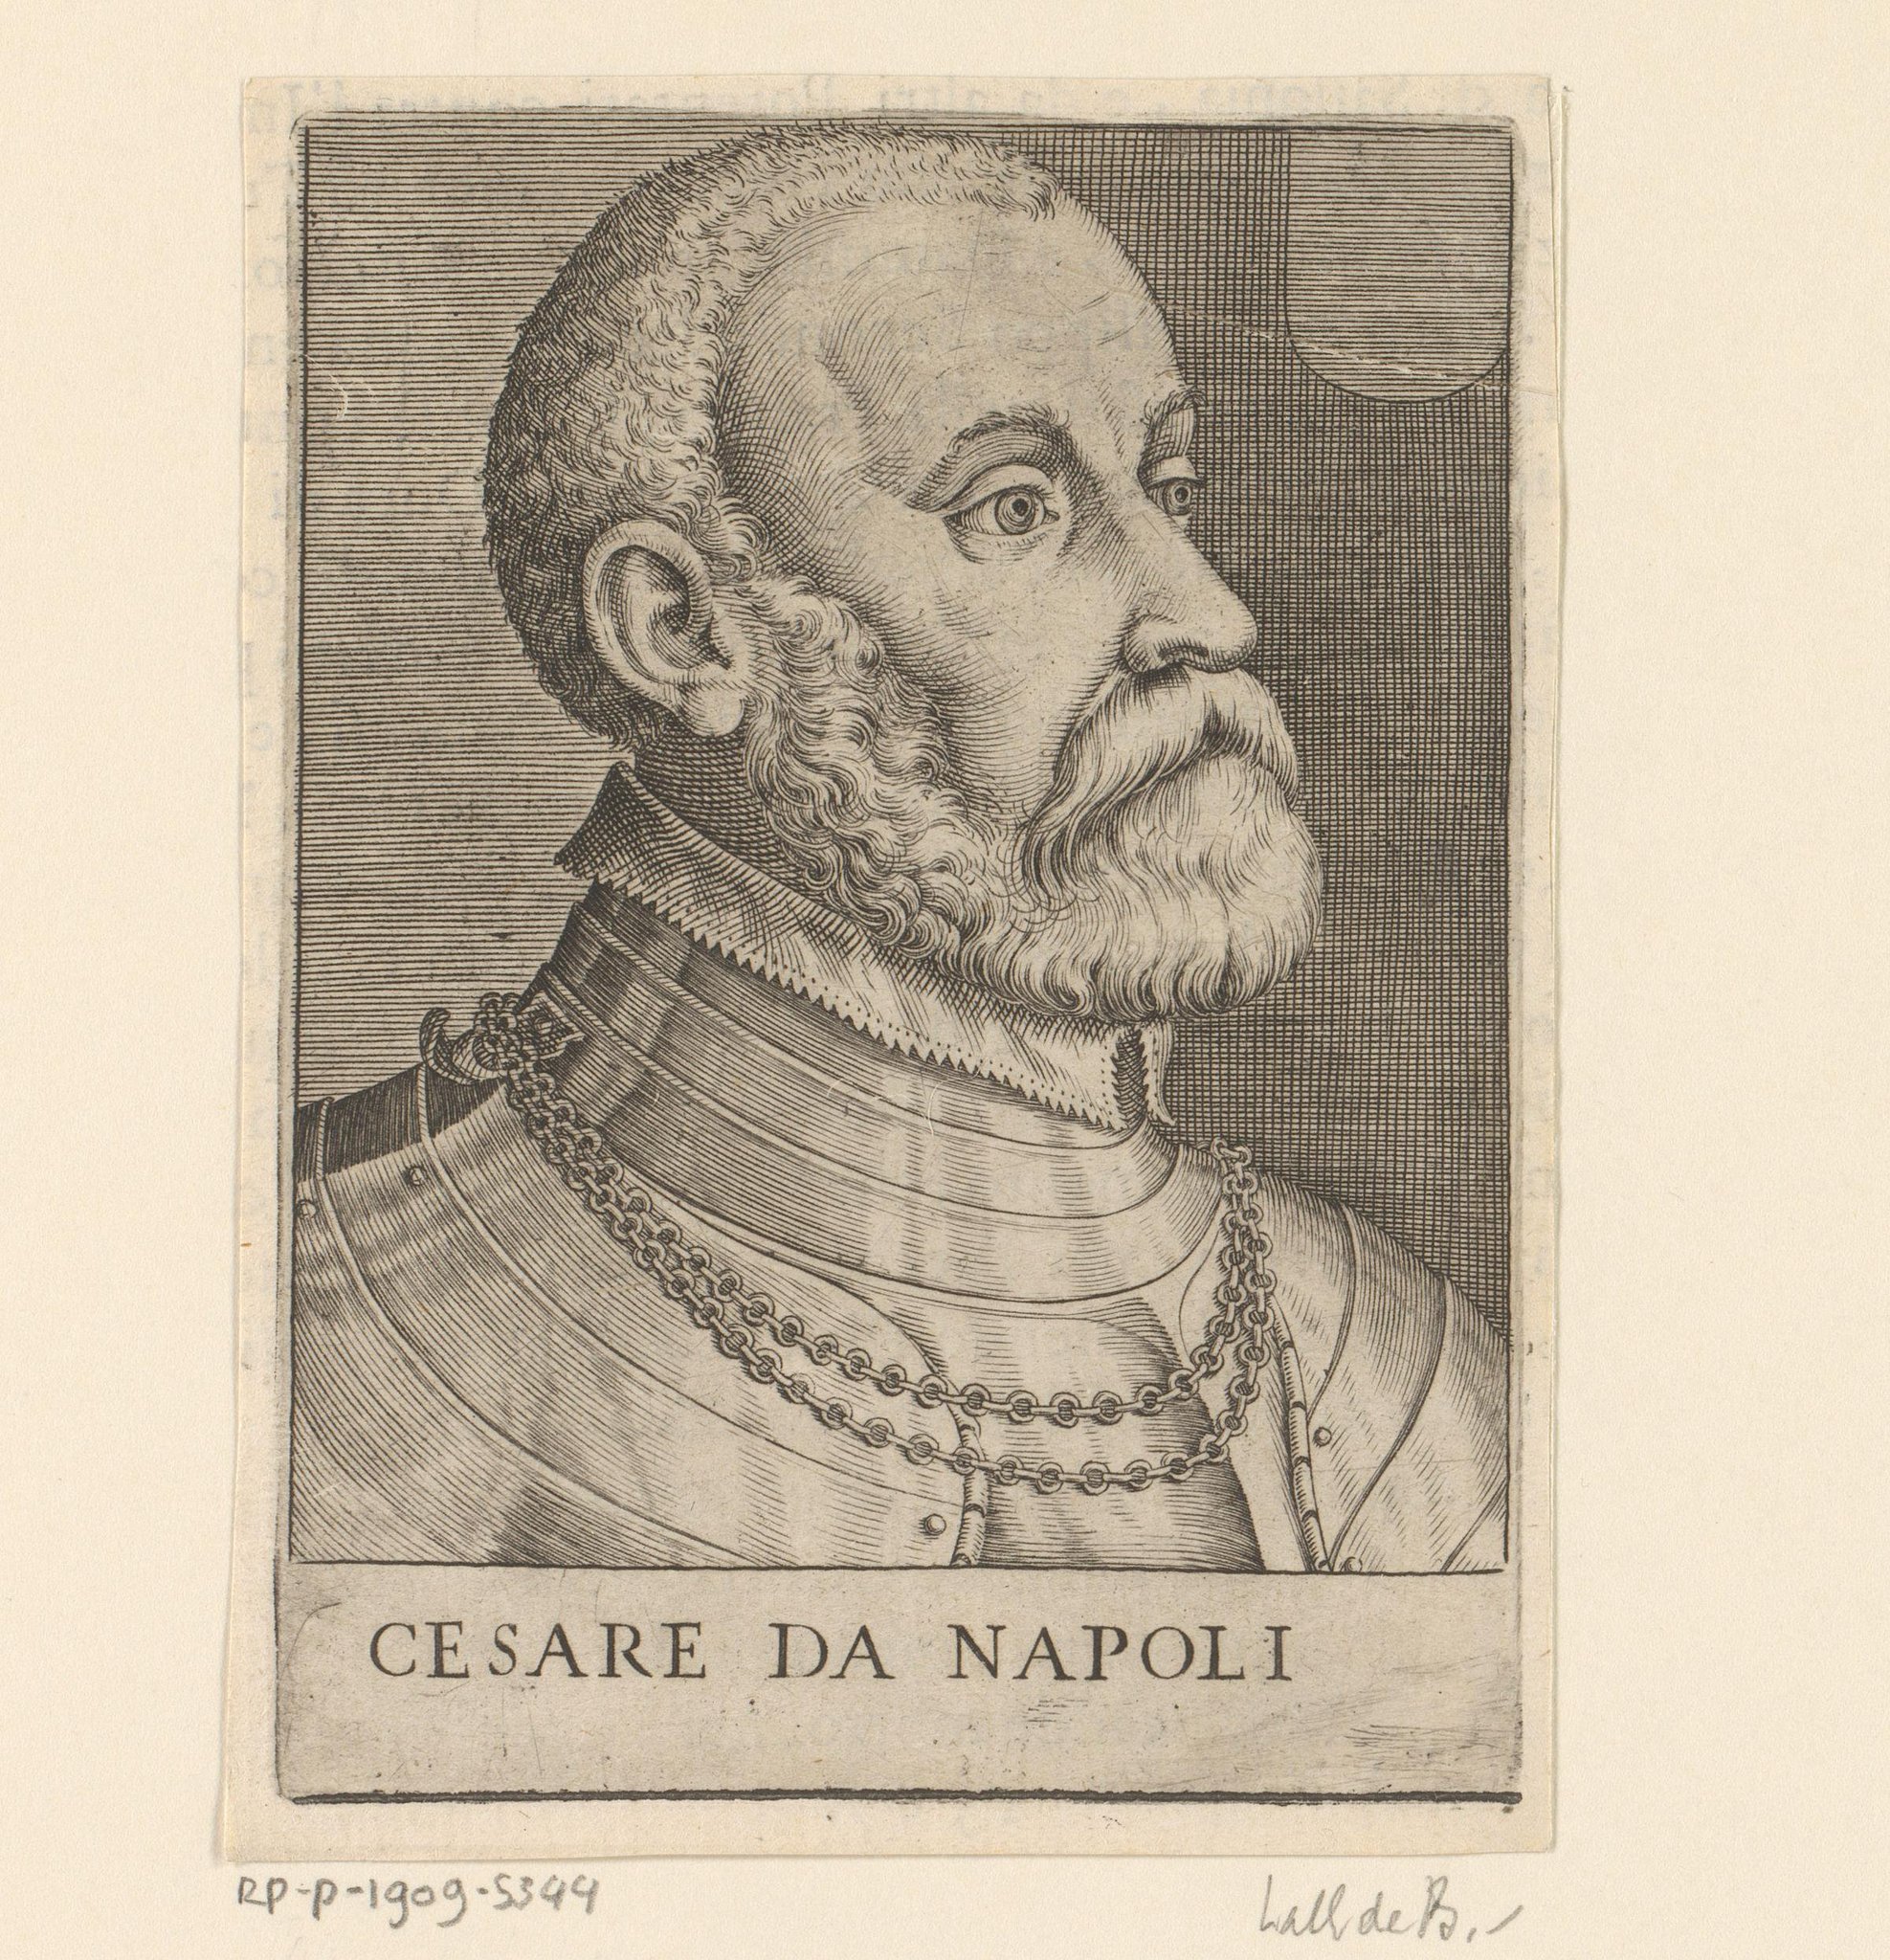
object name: book illustration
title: Portret van legeraanvoerder Cesare Maggi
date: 1646-1647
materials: paper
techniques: engraving, letterpress printing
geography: rome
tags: naples, commander-in-chief, general, marshal, historical persons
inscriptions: collector's mark: Lugt 2228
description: Prent uit: Ritratti et elogii di capitani Illustri. Che ne'secoli moderni hanno gloriosamente guerreggiato. Rome: Filippo de'Rossi en Vitale Mascardi, 1646, p. 328. Prent ook gebruikt in dezelfde editie van 1647. Eerdere staten van prent in ieder geval gebruikt in: Ritratti et elogii di capitani Illustri. Rome: Pompilio Totti en Andrea Fei, 1635. En in: Ritratti di cento capitani illustri con li lor Fatti in guerra (…), Rome: Domenico Gigliotti, 1596.